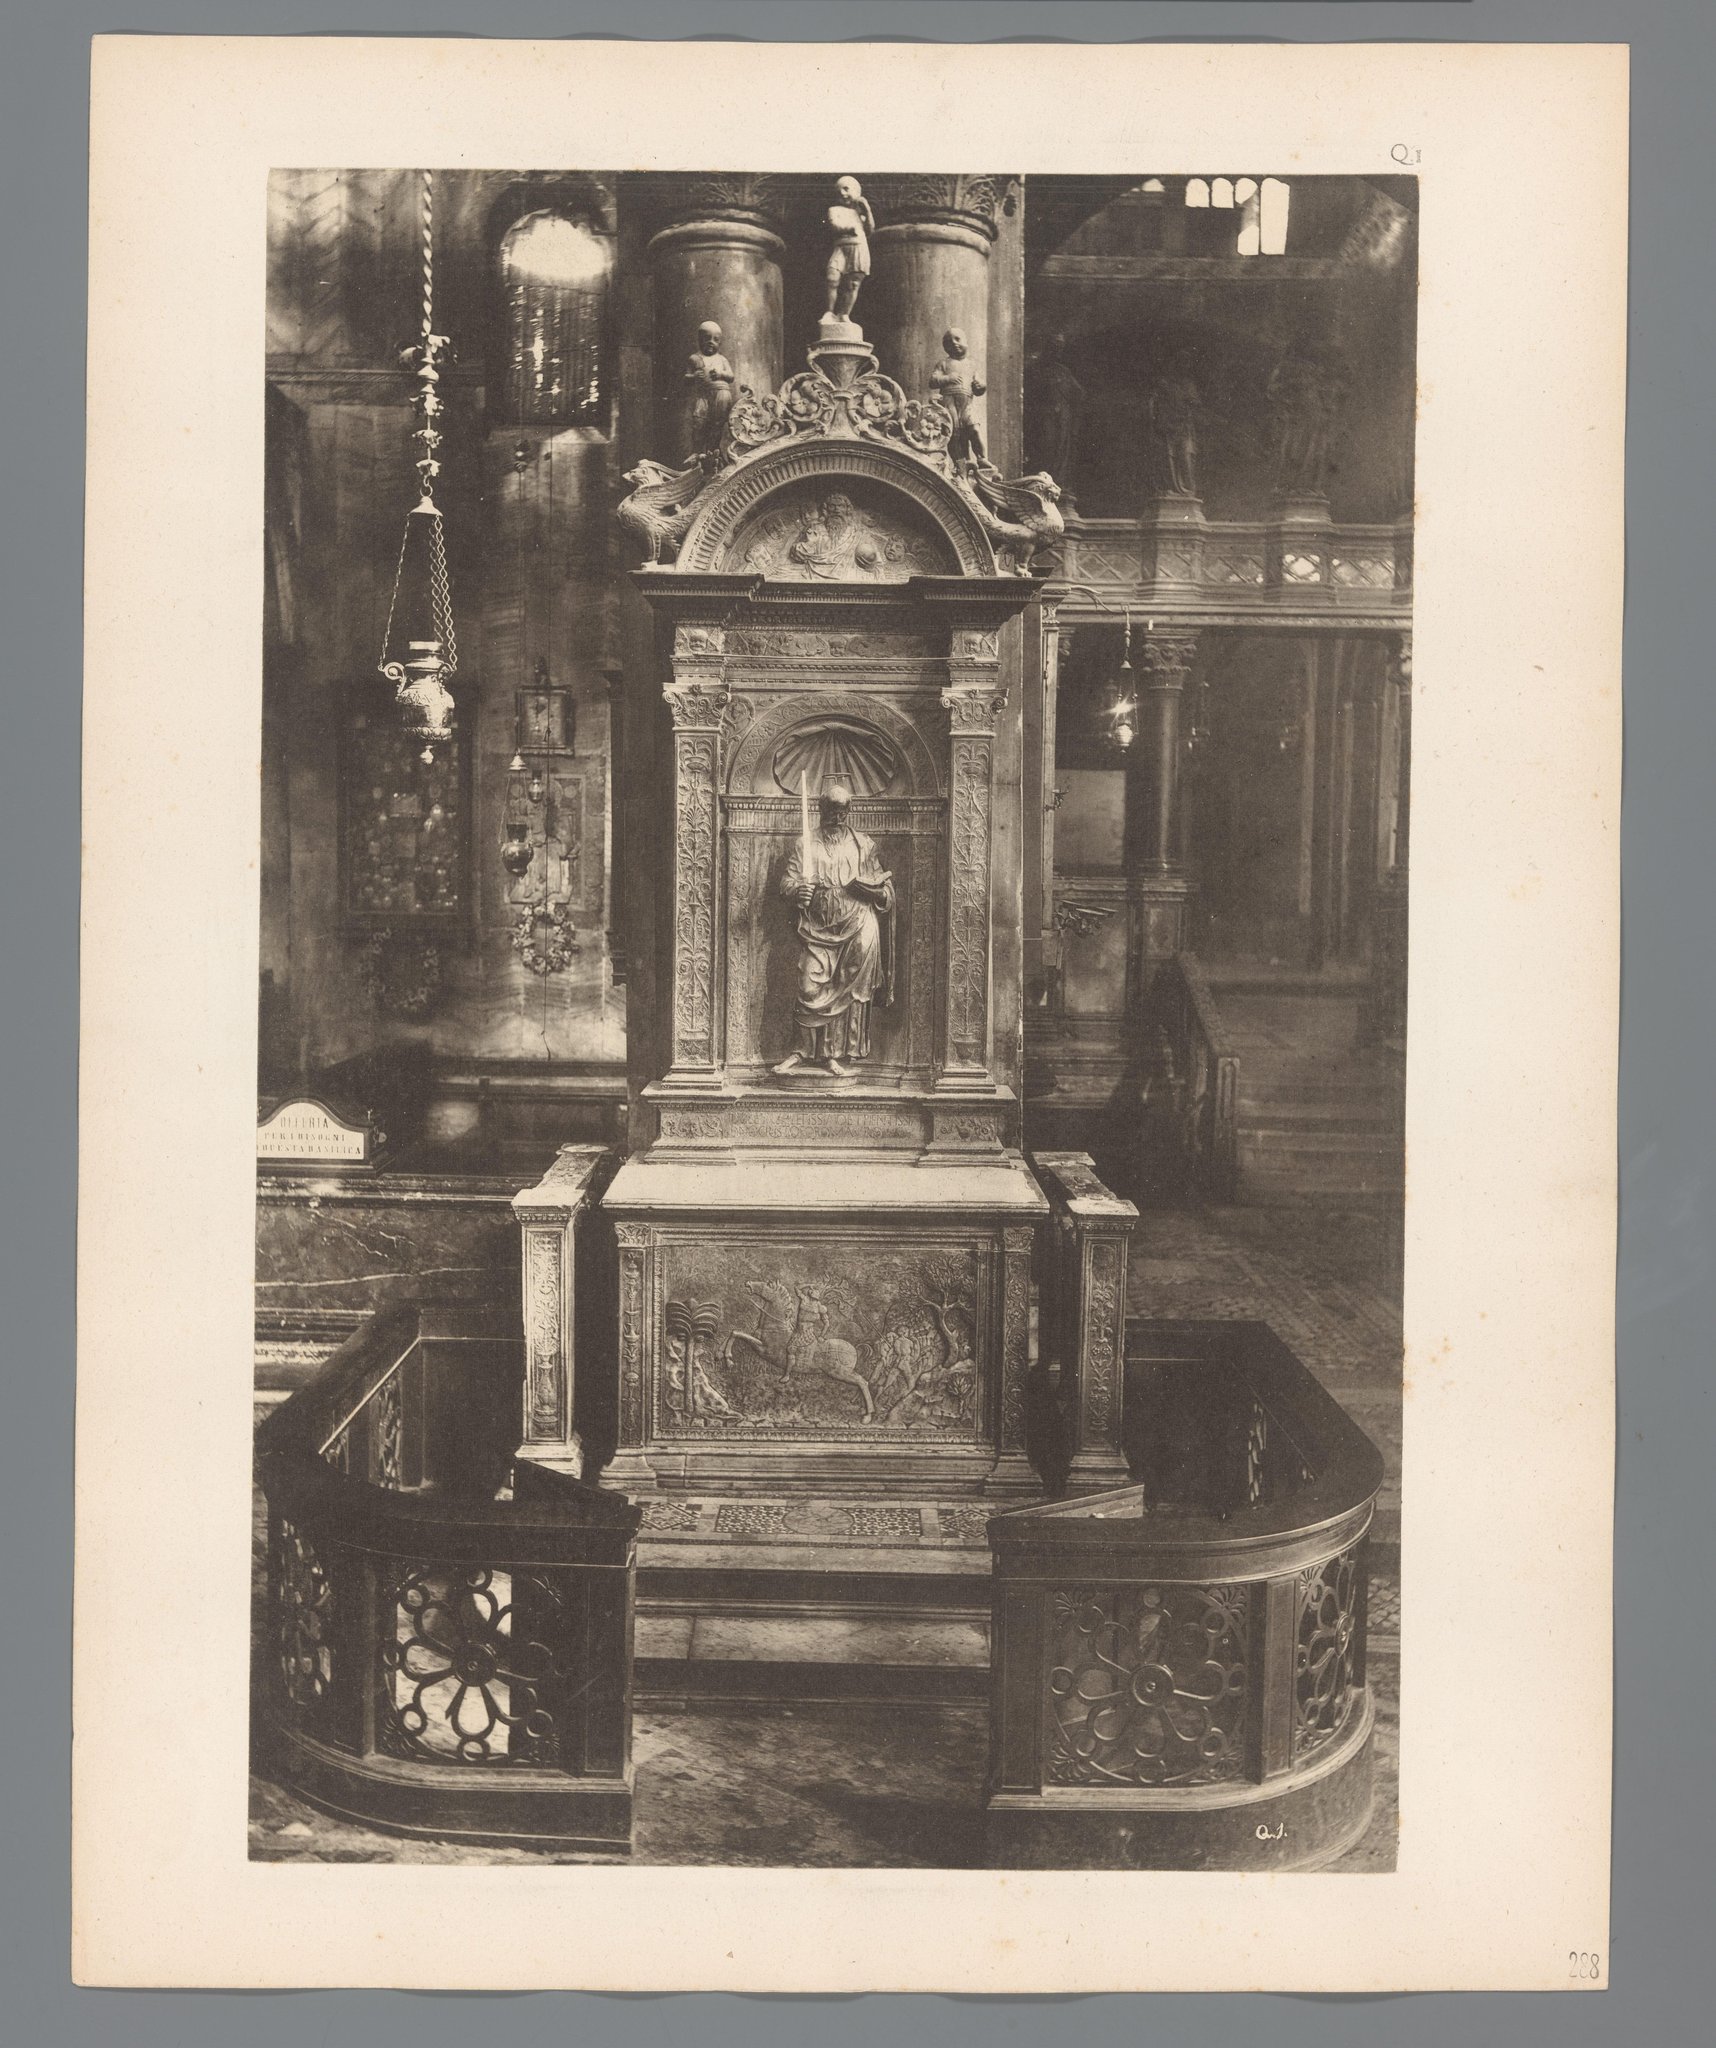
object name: photomechanical print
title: Altaar met sculptuur van een heilige, vermoedelijk Bonifatius, in de San Marco in Venetië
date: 1880-1885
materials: paper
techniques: photograph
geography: st. mark's basilica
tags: the martyr boniface, 'apostle of germany', and archbishop of mainz; possible attributes: axe in root of tree, book pierced by a sword, fountain (springing up from under his staff), whip, piece of sculpture, reproduction of a piece of sculpture, fixed altar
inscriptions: number: ‘Q.I’, number: ‘288’, number: ‘Q.1.’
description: Deze prent maakt deel uit van een omslag met 58 prenten op 50 bladen.